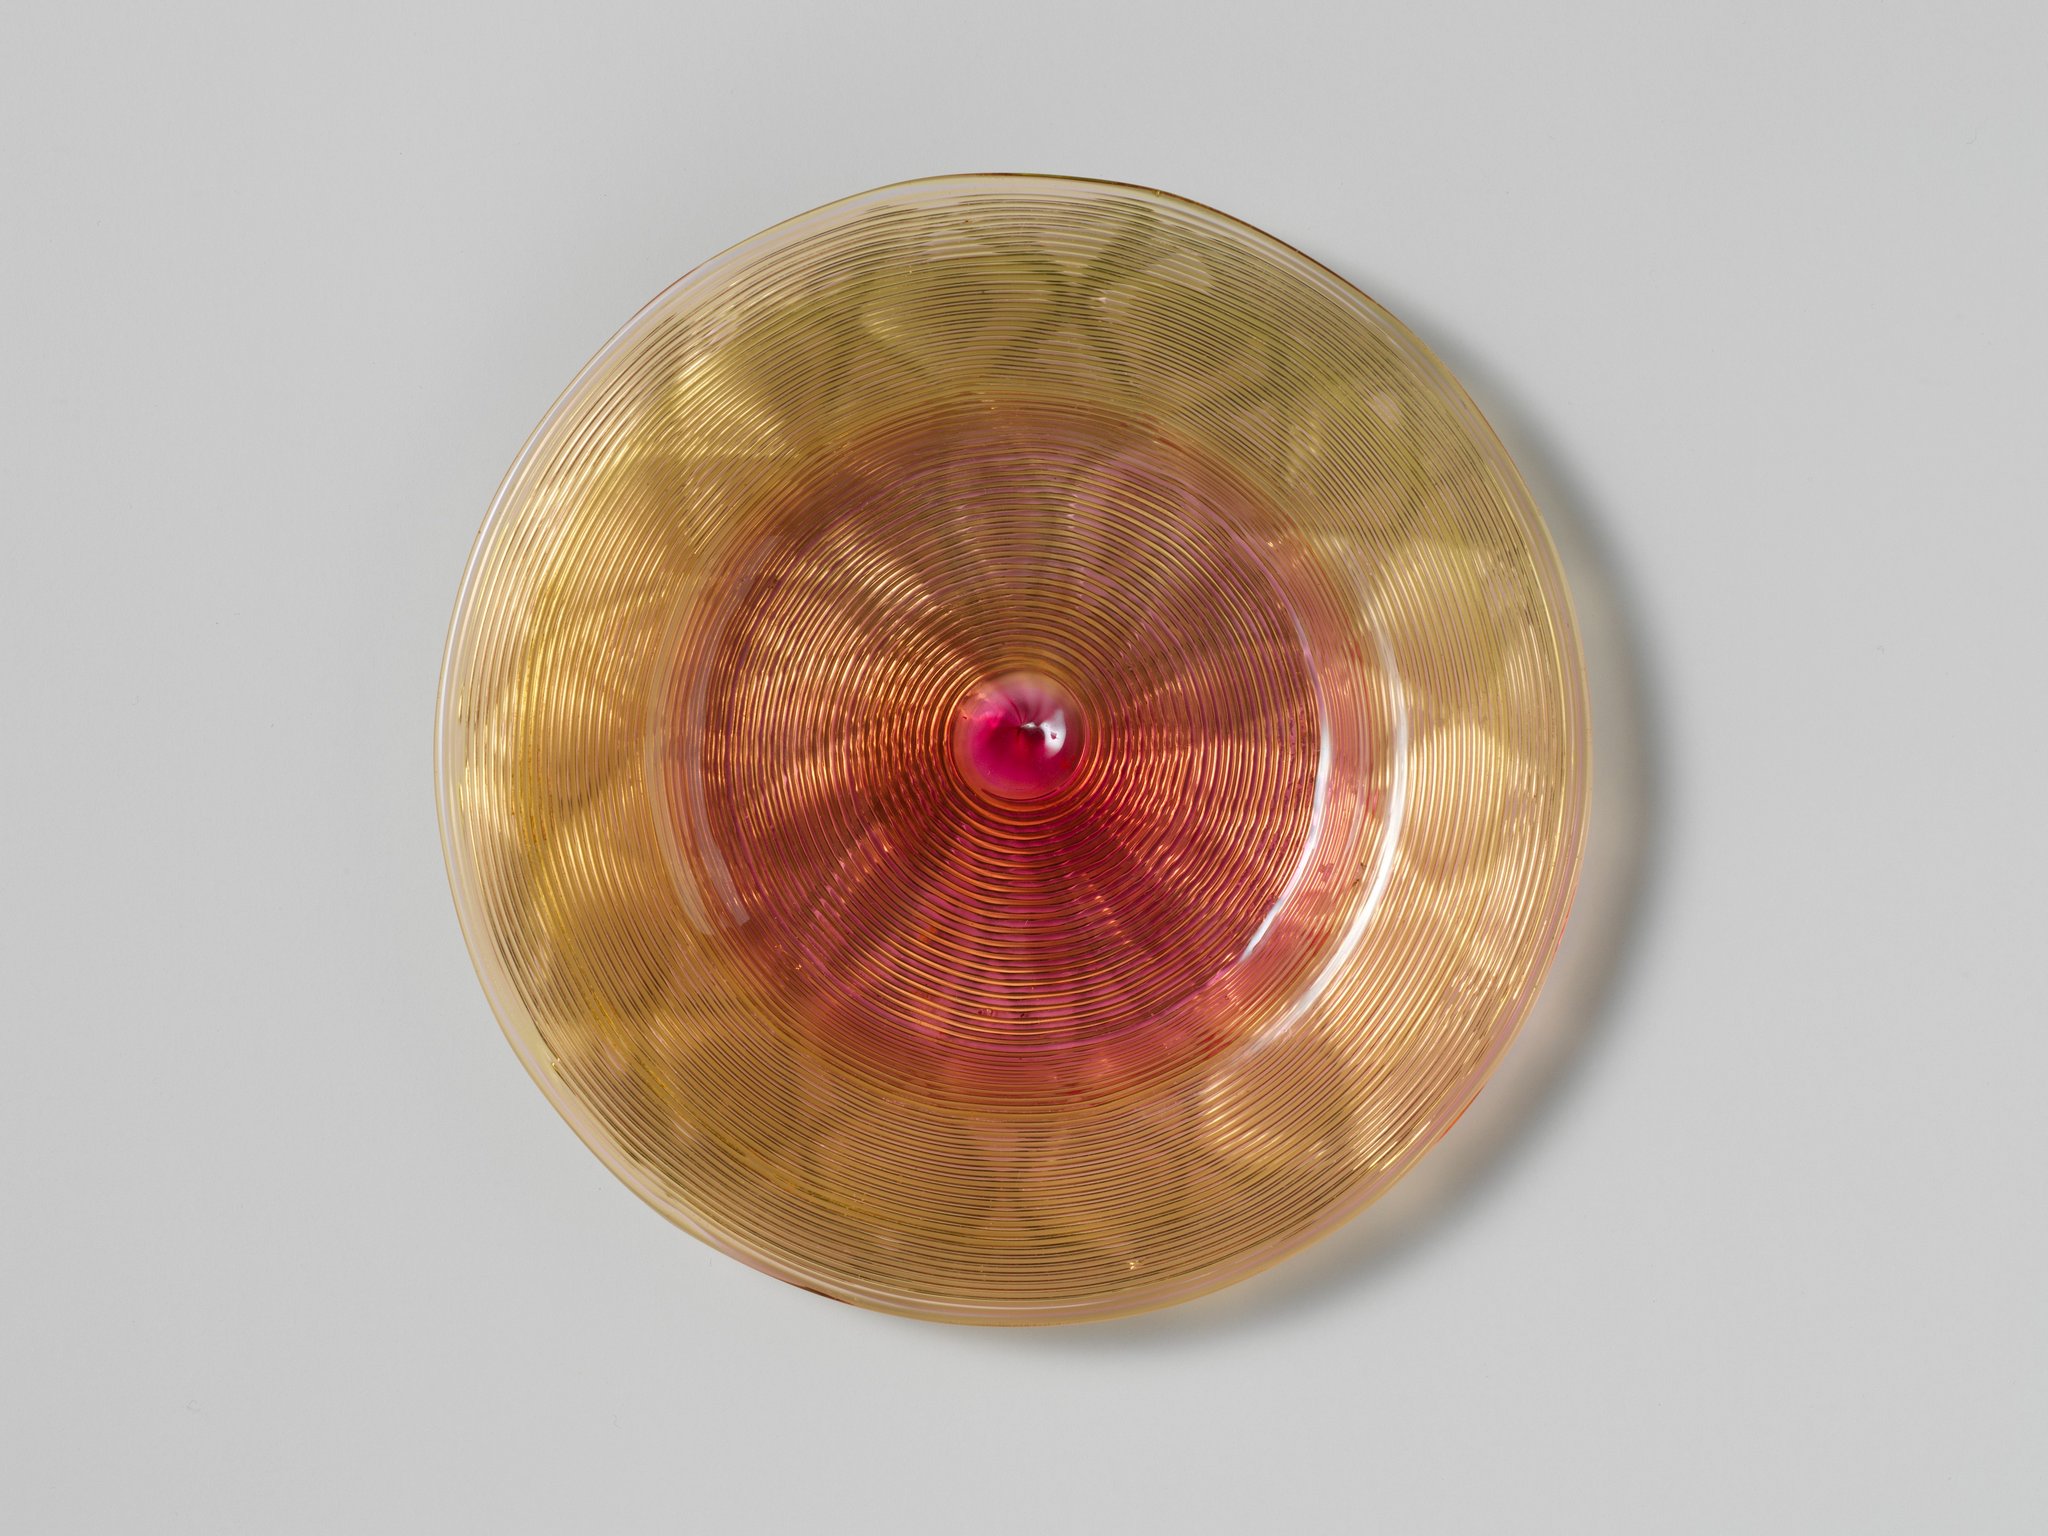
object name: plate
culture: american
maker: boston & sandwich glass company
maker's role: maker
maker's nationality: american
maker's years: 1825-1888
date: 1880-1888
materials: amber, glass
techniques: glassblowing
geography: united states